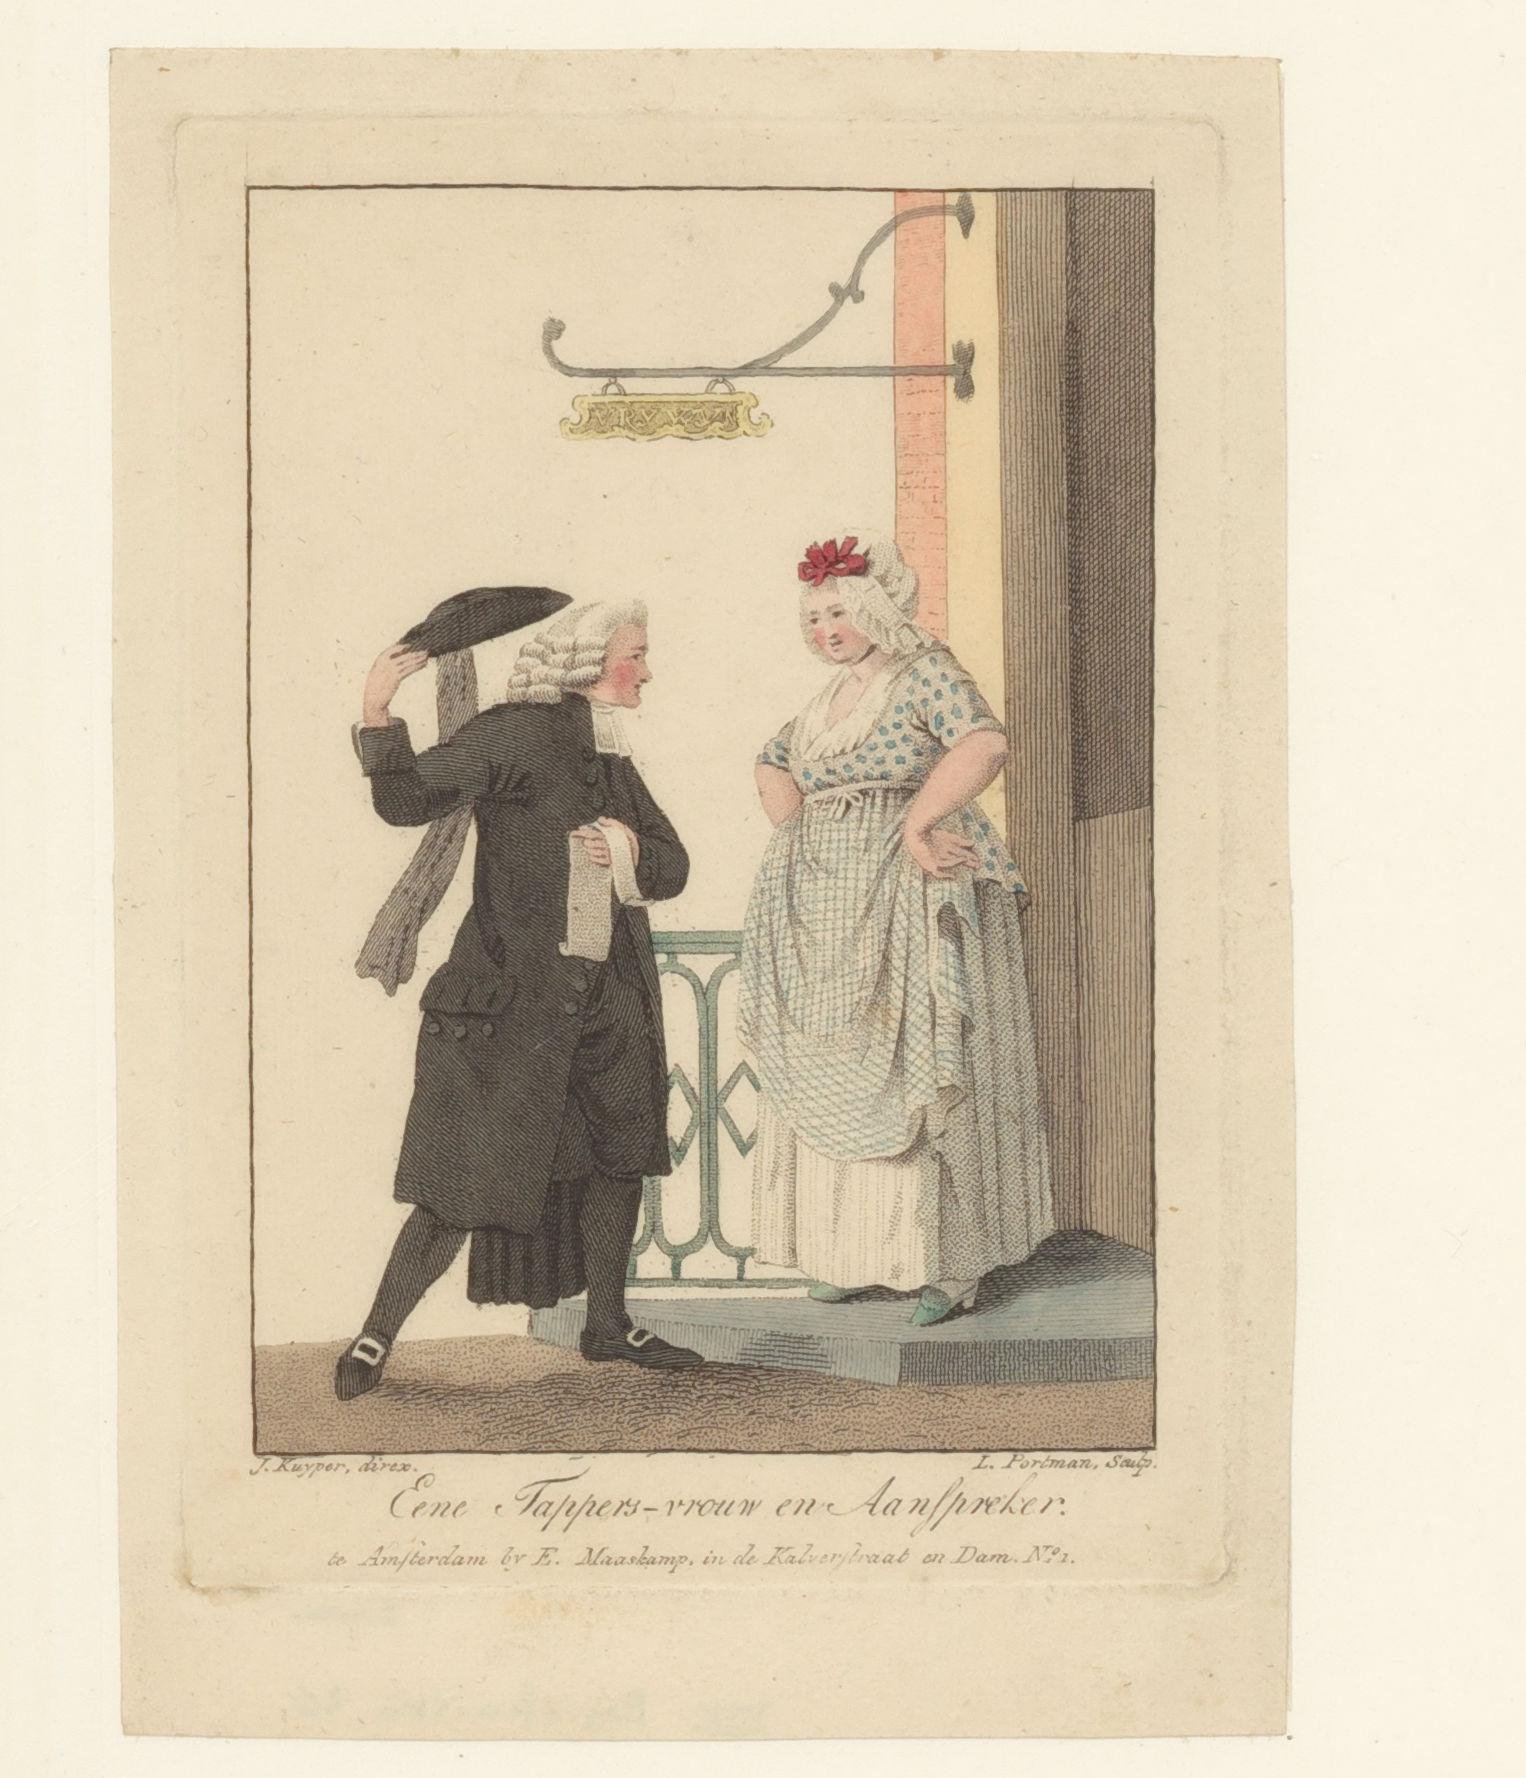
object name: book illustration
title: Aanspreker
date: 1806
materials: paper, watercolor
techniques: etching, hand coloring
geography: netherlands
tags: oral announcement (of death), undertaker's man, inn, coffee-house, public house, etc., clothes, costume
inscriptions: collector's mark, collector's mark: Lugt 1641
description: Een aanspreker (aanzegger) deelt het overlijden van iemand mee aan een huisvrouw in de deuropening van een wijnhuis. Op het uithangbord: Vry Wyn. Onderdeel van de serie verkleinde kopieën uit 1806 naar de platen van Nederlandse klederdrachten uit de jaren 1803-1807. Onderwerpsrubrieken binnen de Atlas Zeden en Gewoonten: Des Menschen Begin, Midden en Einde. Begrafenissen, aansprekers, doodgravers, enz.